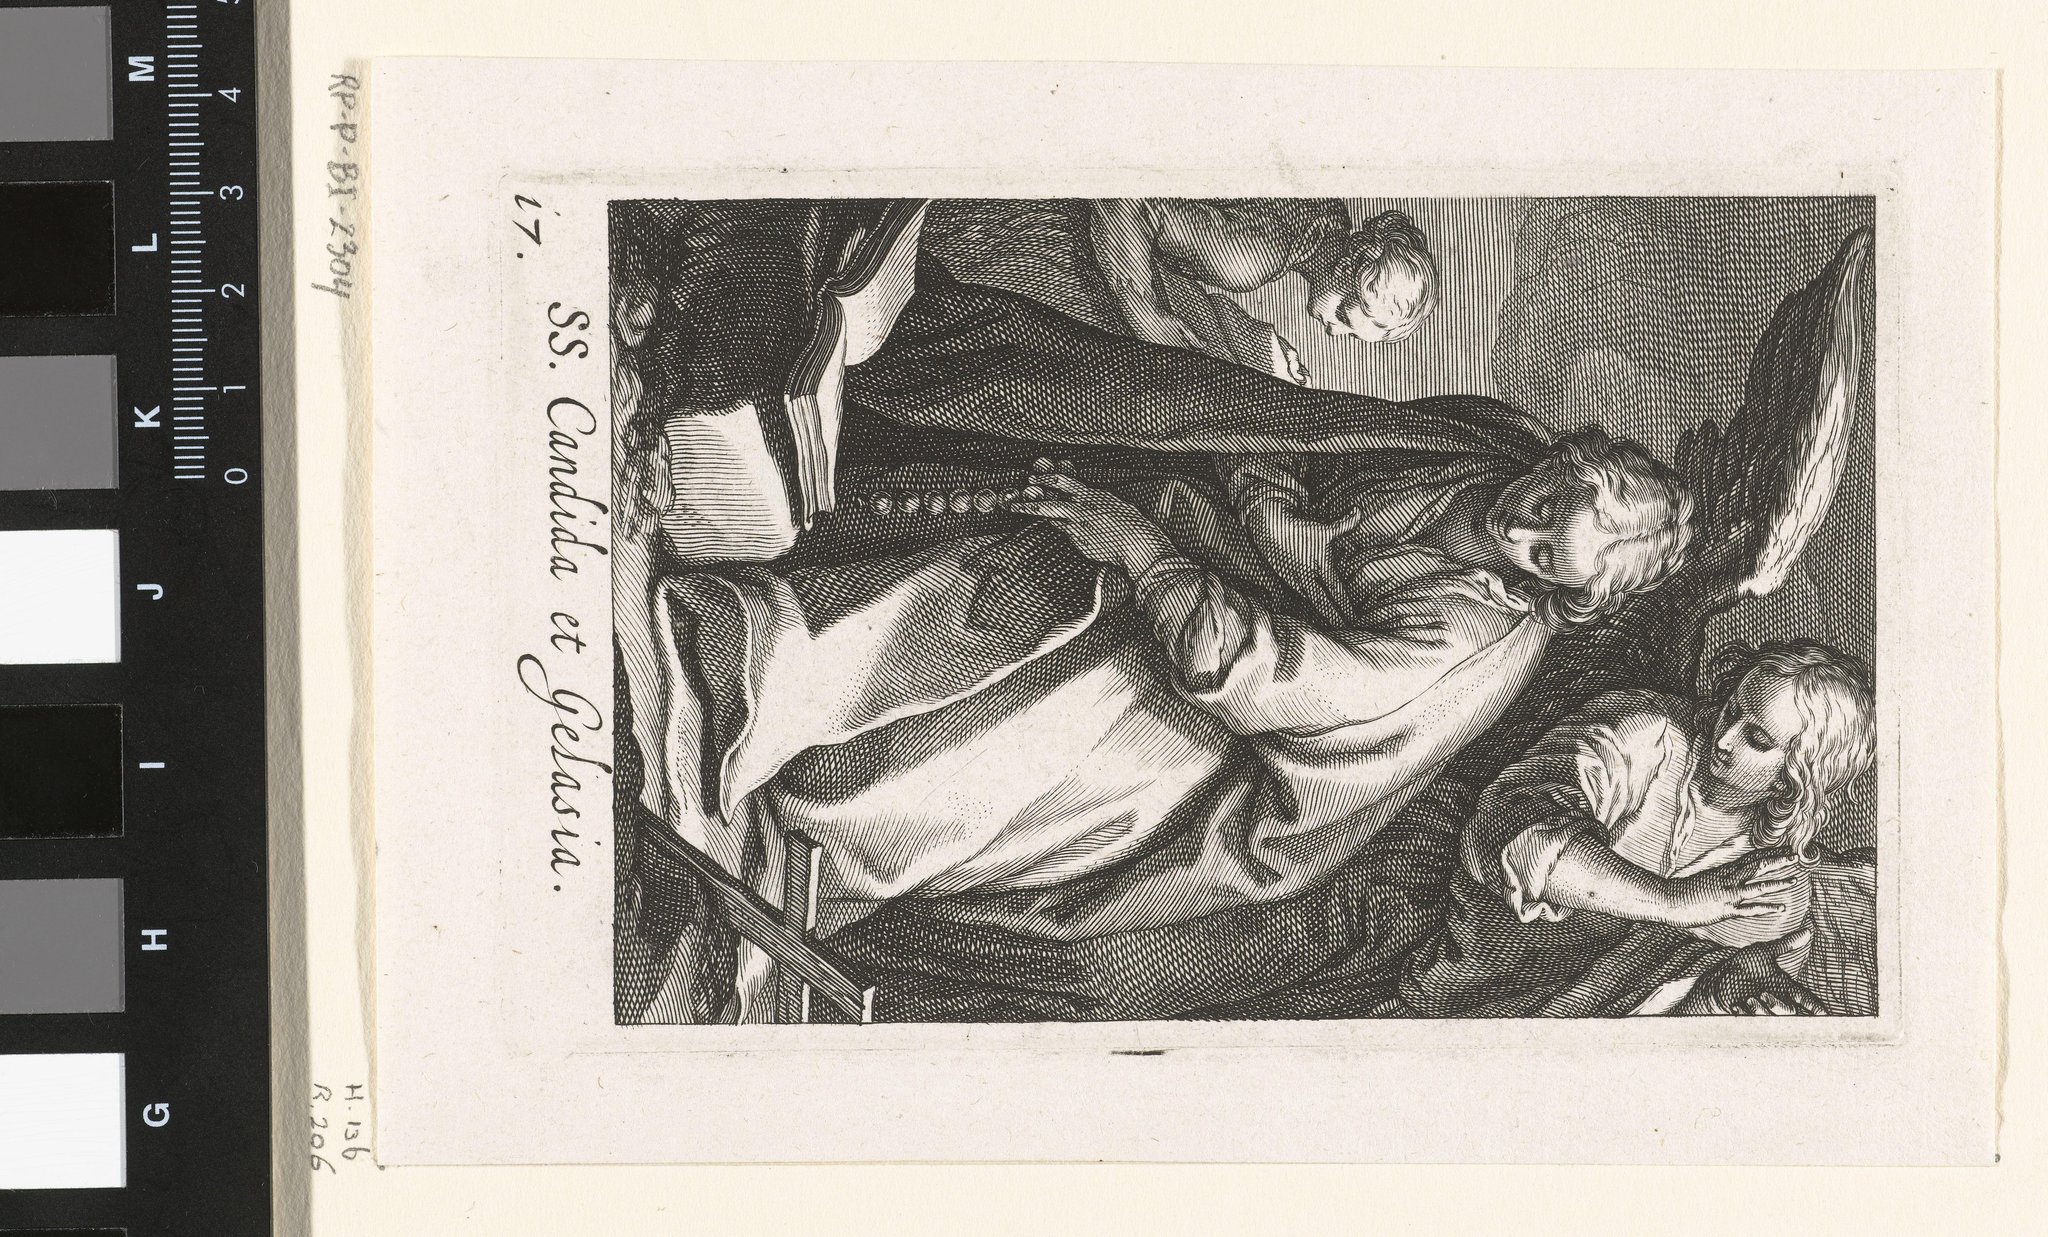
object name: print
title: Sacra Eremus Ascetriarum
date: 1590-1612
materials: paper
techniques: engraving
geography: low countries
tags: anchorite, hermit, female saints, angels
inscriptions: collector's mark: Lugt 2228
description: Prent uit: Sacra Eremus Ascetriarum, uitgever Boëtius Adamsz. Bolswert, 1612 of Hendrik Aertssen, Antwerpen 1619. Prent uit de serie van vijfentwintig kluizenaressen in deze uitgaven. In 1612 verscheen een ongebonden editie maar op basis van de gewijzigde opschriften en samenstelling van de serie kluizenaars wordt aangenomen dat de prenten van de uitgave 1619 ook in 1612 of iets daarvoor gedrukt werden. De serie kluizenaressen bleef vrijwel ongewijzigd in de ongebonden uitgave van 1612, dit compliceert de datering van de losse bladen in de collectie van het RMA, zie Roethlisberger 1993, p. 171-175.